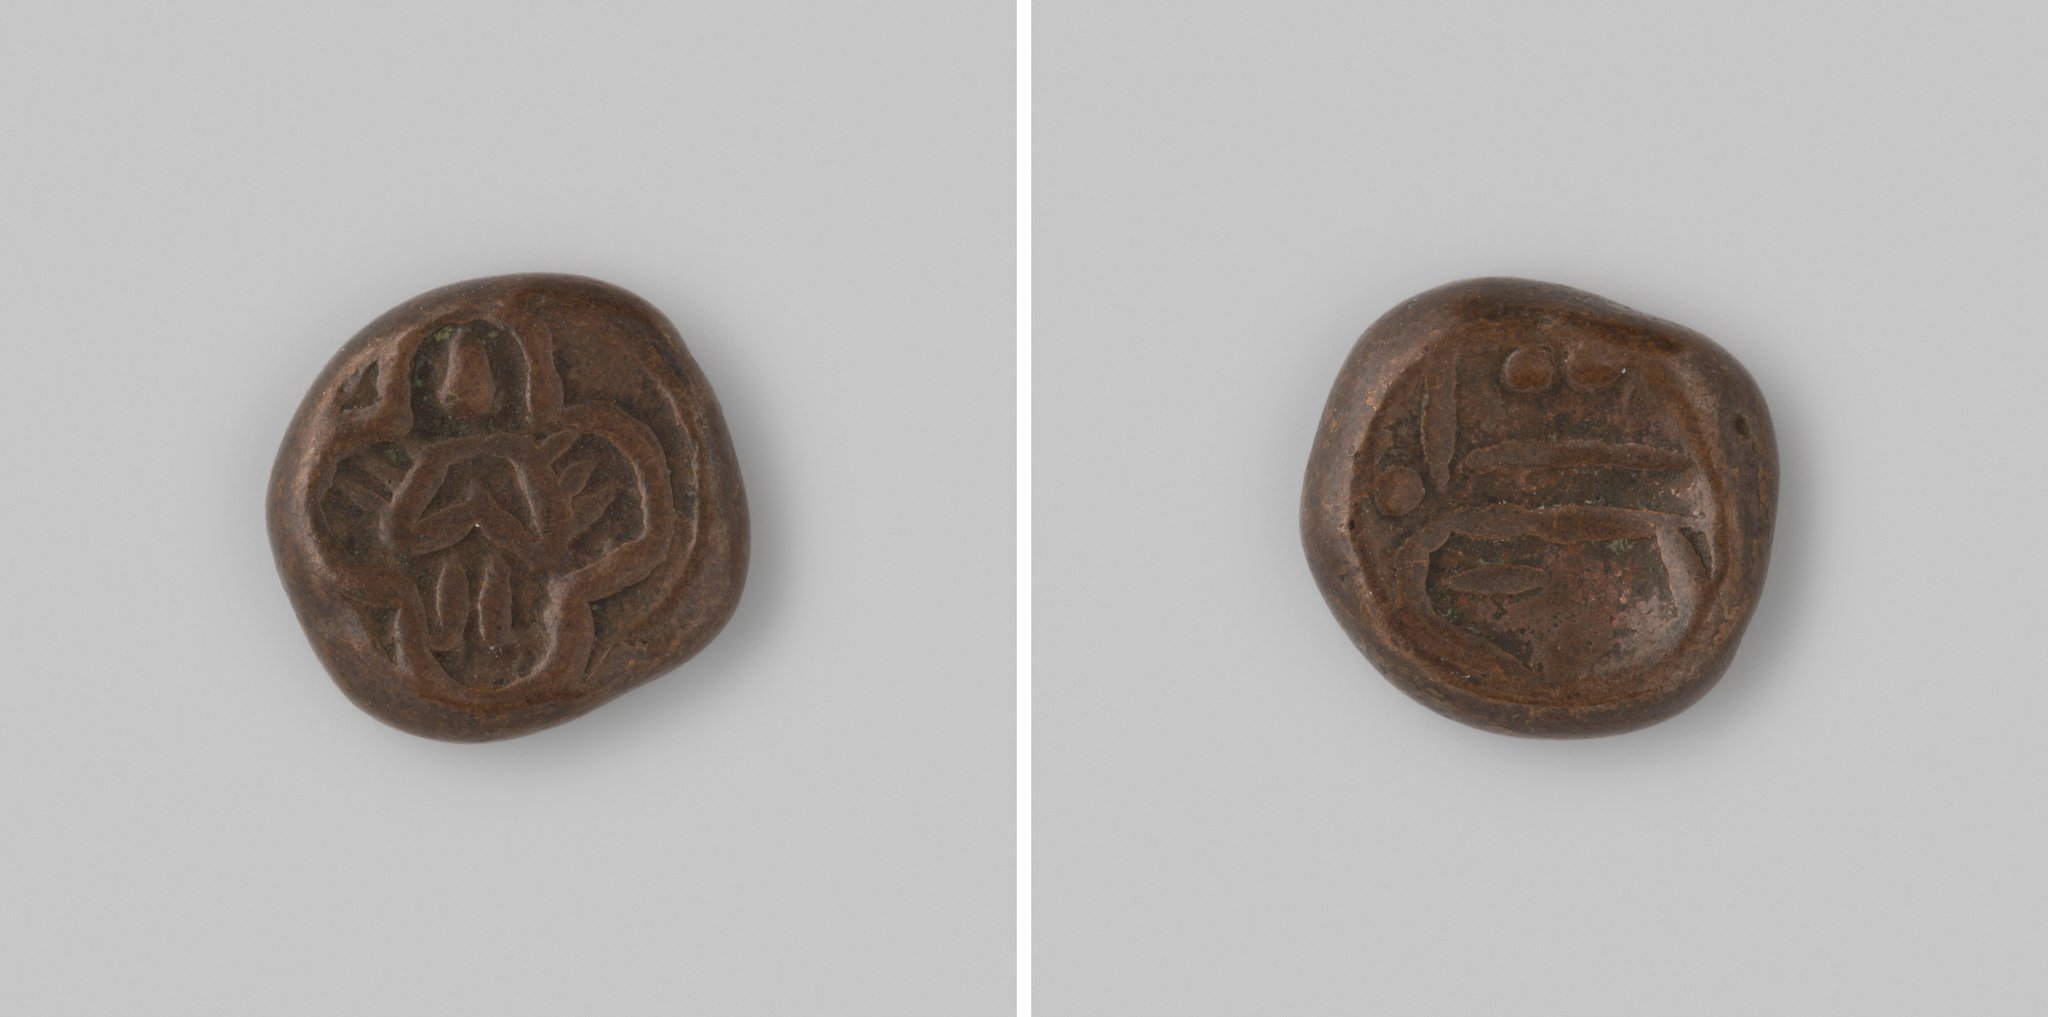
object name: coin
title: Cash uit India van de Nawabs van Arcot,1690-1825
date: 1745-1825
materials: copper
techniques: striking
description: Koperen munt. Voorzijde: binnen vierpas aanziende godheid met vleugels: garuda. Keerzijde: in Arabisch schrift in twee regels aanduiding muntplaats: Nahtarnagar [=Trichinopoly]..